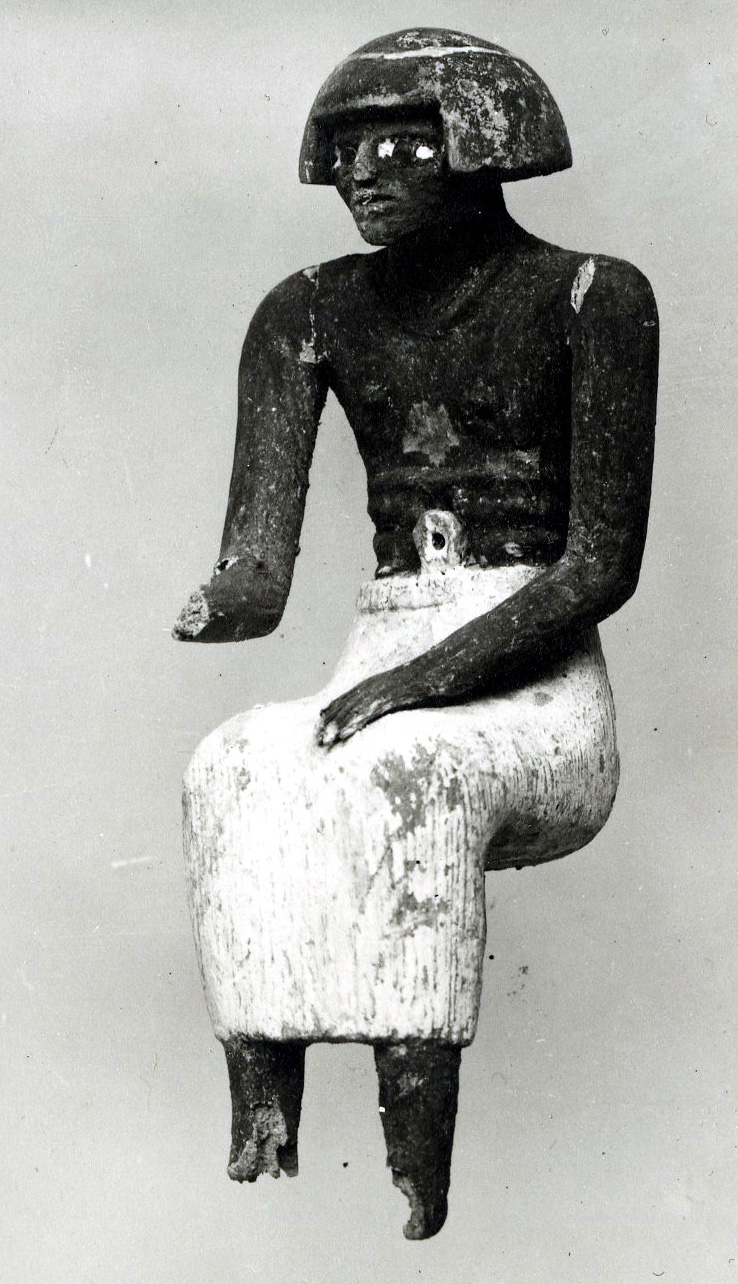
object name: statuette, seated man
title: Figure of a Seated Man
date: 2030-1640 BCE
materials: paint, wood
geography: egypt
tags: men,portraits